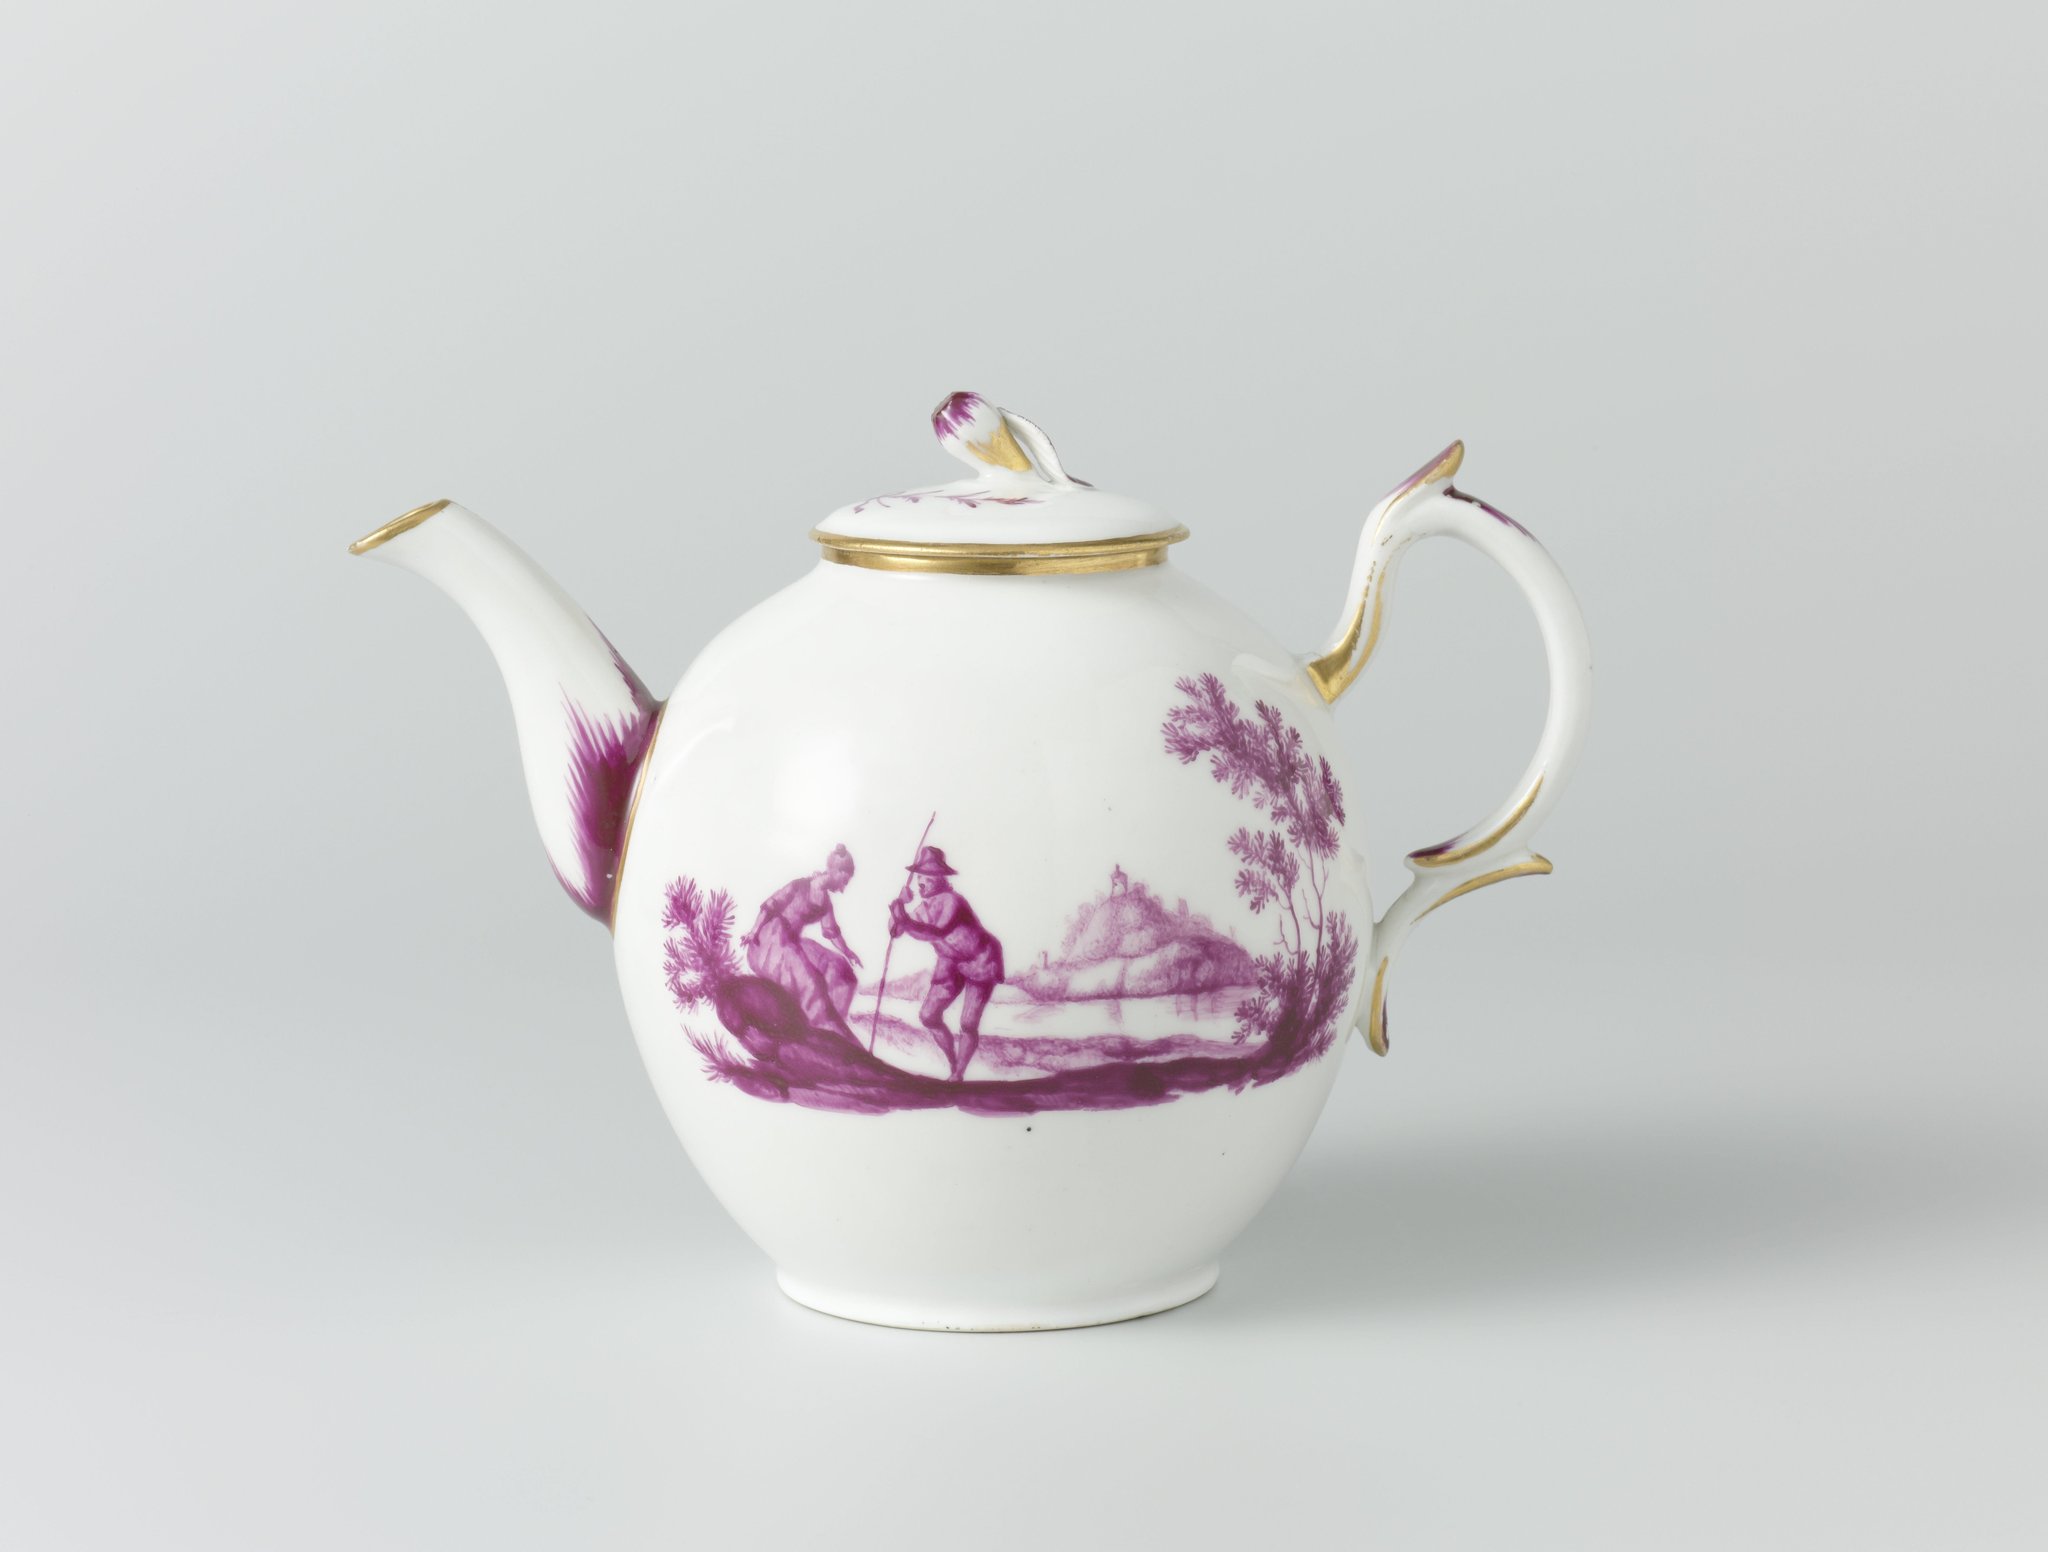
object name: teapot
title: Part of a tea service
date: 1774-1778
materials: porcelain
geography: loosdrecht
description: Manufactuur Oud-Loosdrecht Loosdrecht, c. 1774–1778 tea caddy: c. 1782 hard-paste porcelain